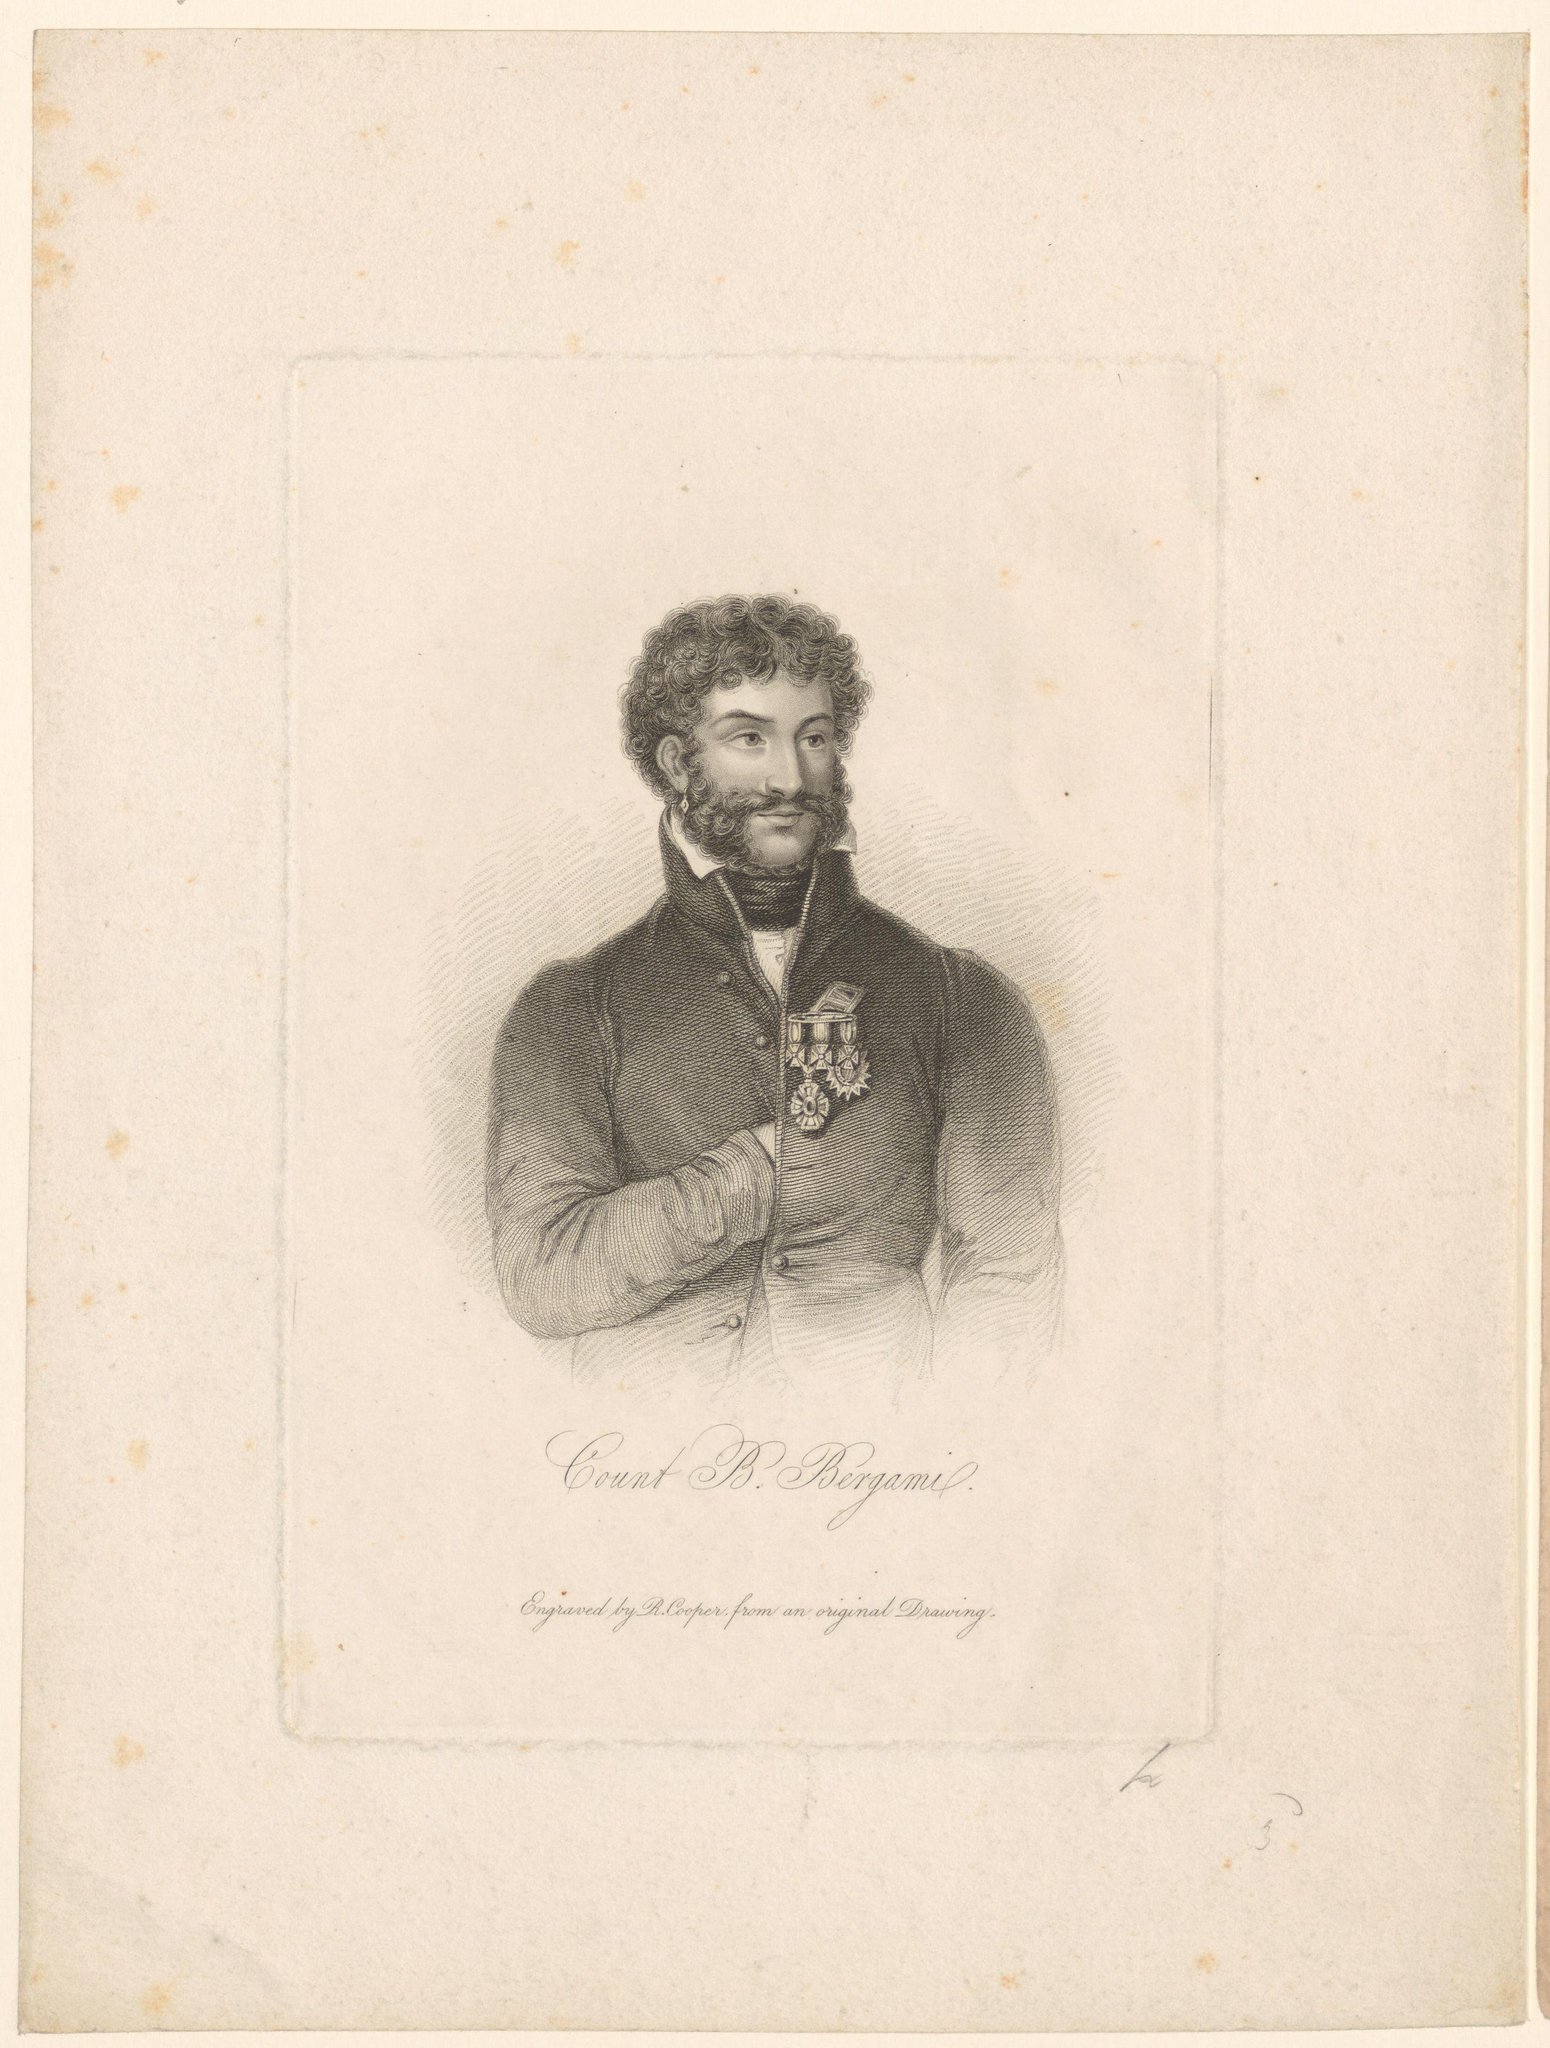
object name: print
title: Portret van Bartolomeo Bergami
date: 1820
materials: paper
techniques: etching, roulette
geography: england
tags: earl, arm or hand held in front of the chest, historical persons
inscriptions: collector's mark: Lugt 2228